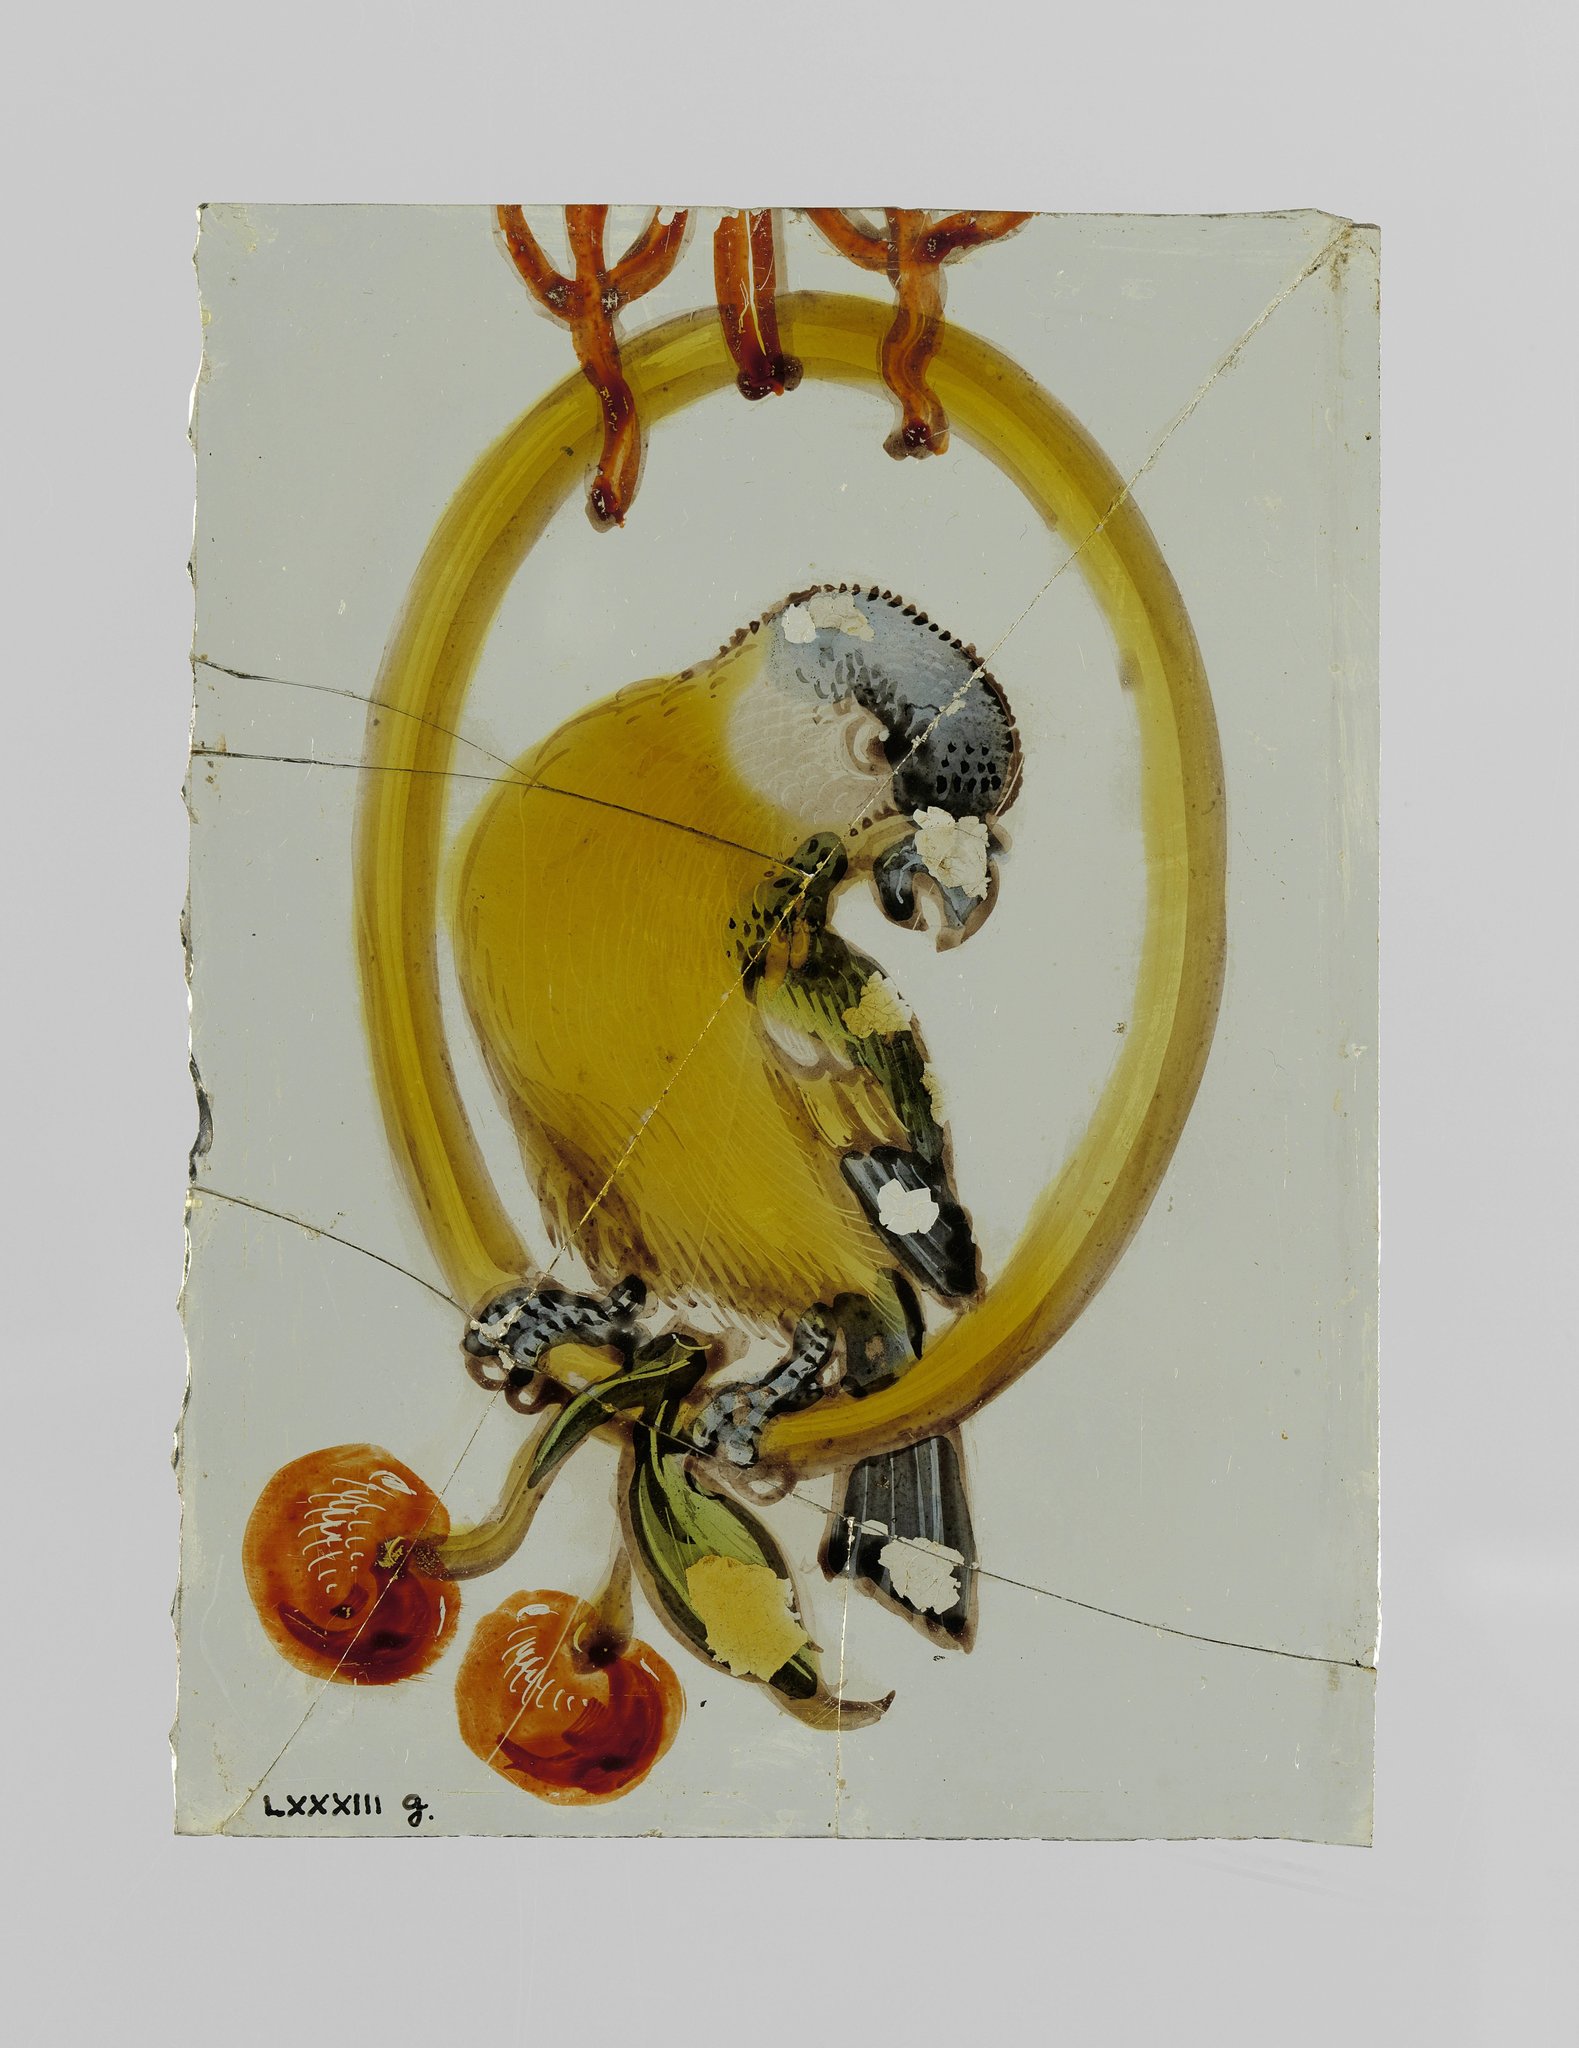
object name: light window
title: Ruit met een vogel gezeten in een ring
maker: Anonymous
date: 1650-1675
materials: glass, lead, pigment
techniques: enamel painting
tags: birds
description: Een ruitje met emailschildering van een vogel gezeten in een ring in voornamelijk blauw en zilvergeel.